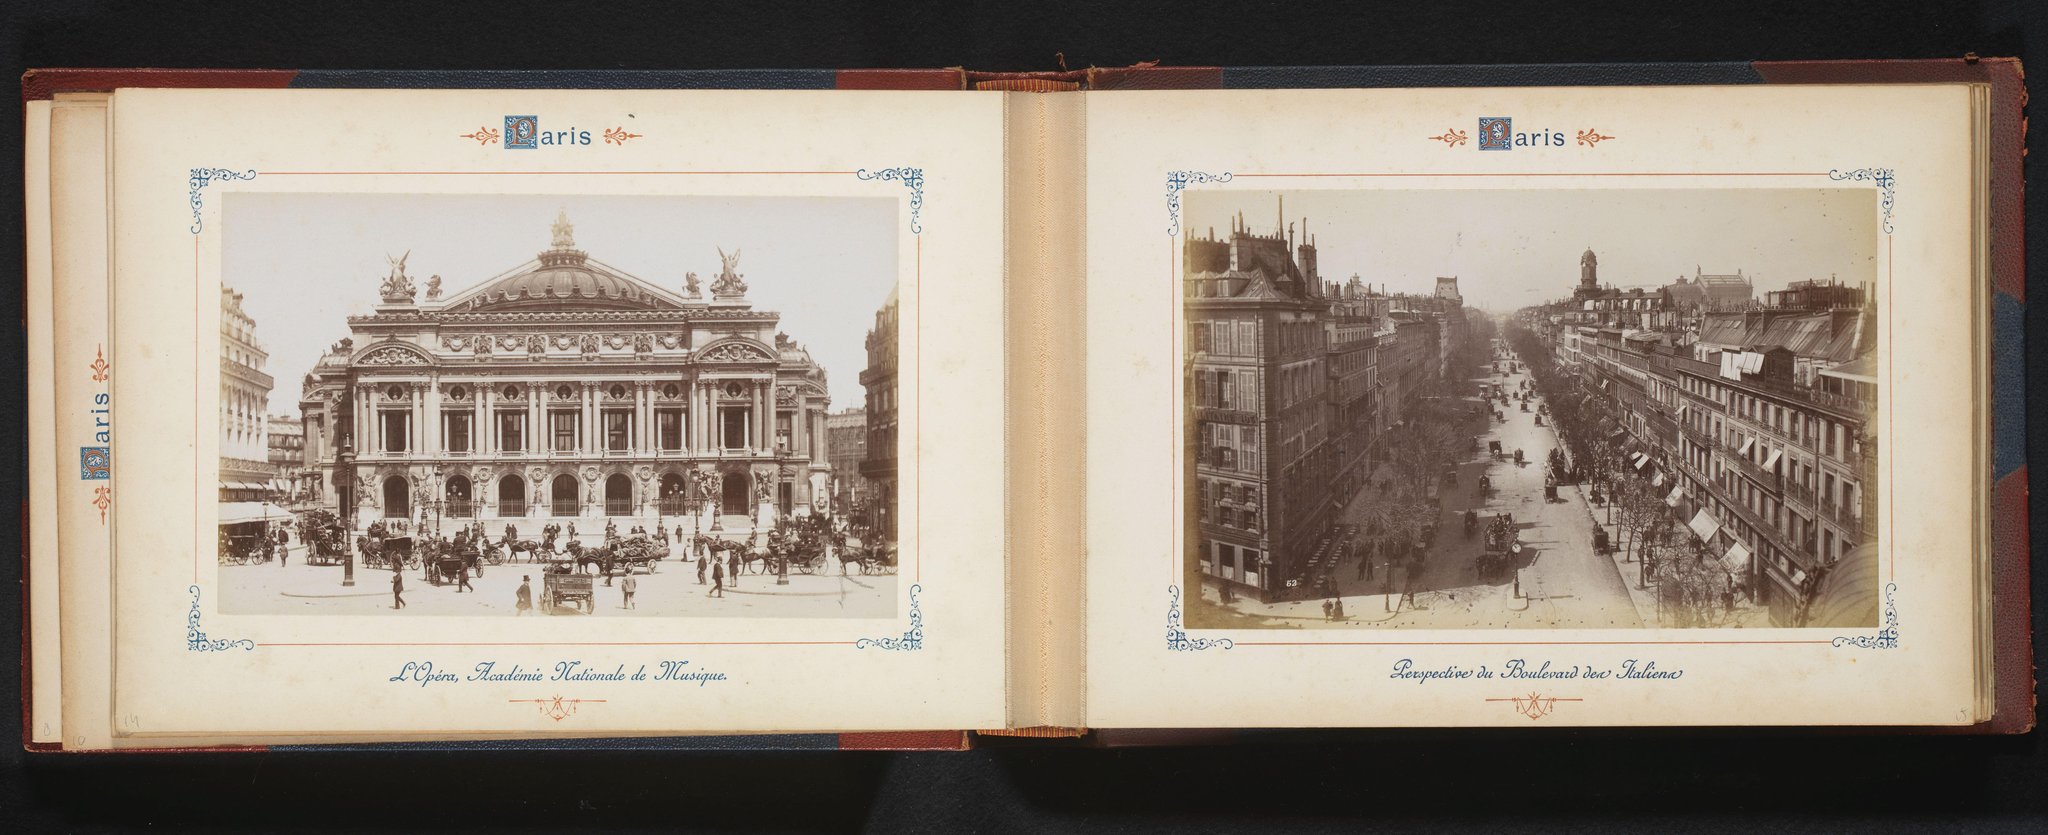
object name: photograph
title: L'Opéra, Académie Nationale de Musique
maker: Anonymous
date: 1879-1889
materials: photographic support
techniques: albumen print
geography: paris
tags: four-wheeled, animal-drawn vehicle, e.g.: cab, carriage, coach, façade (of house or building), opera house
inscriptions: number: ‘73’